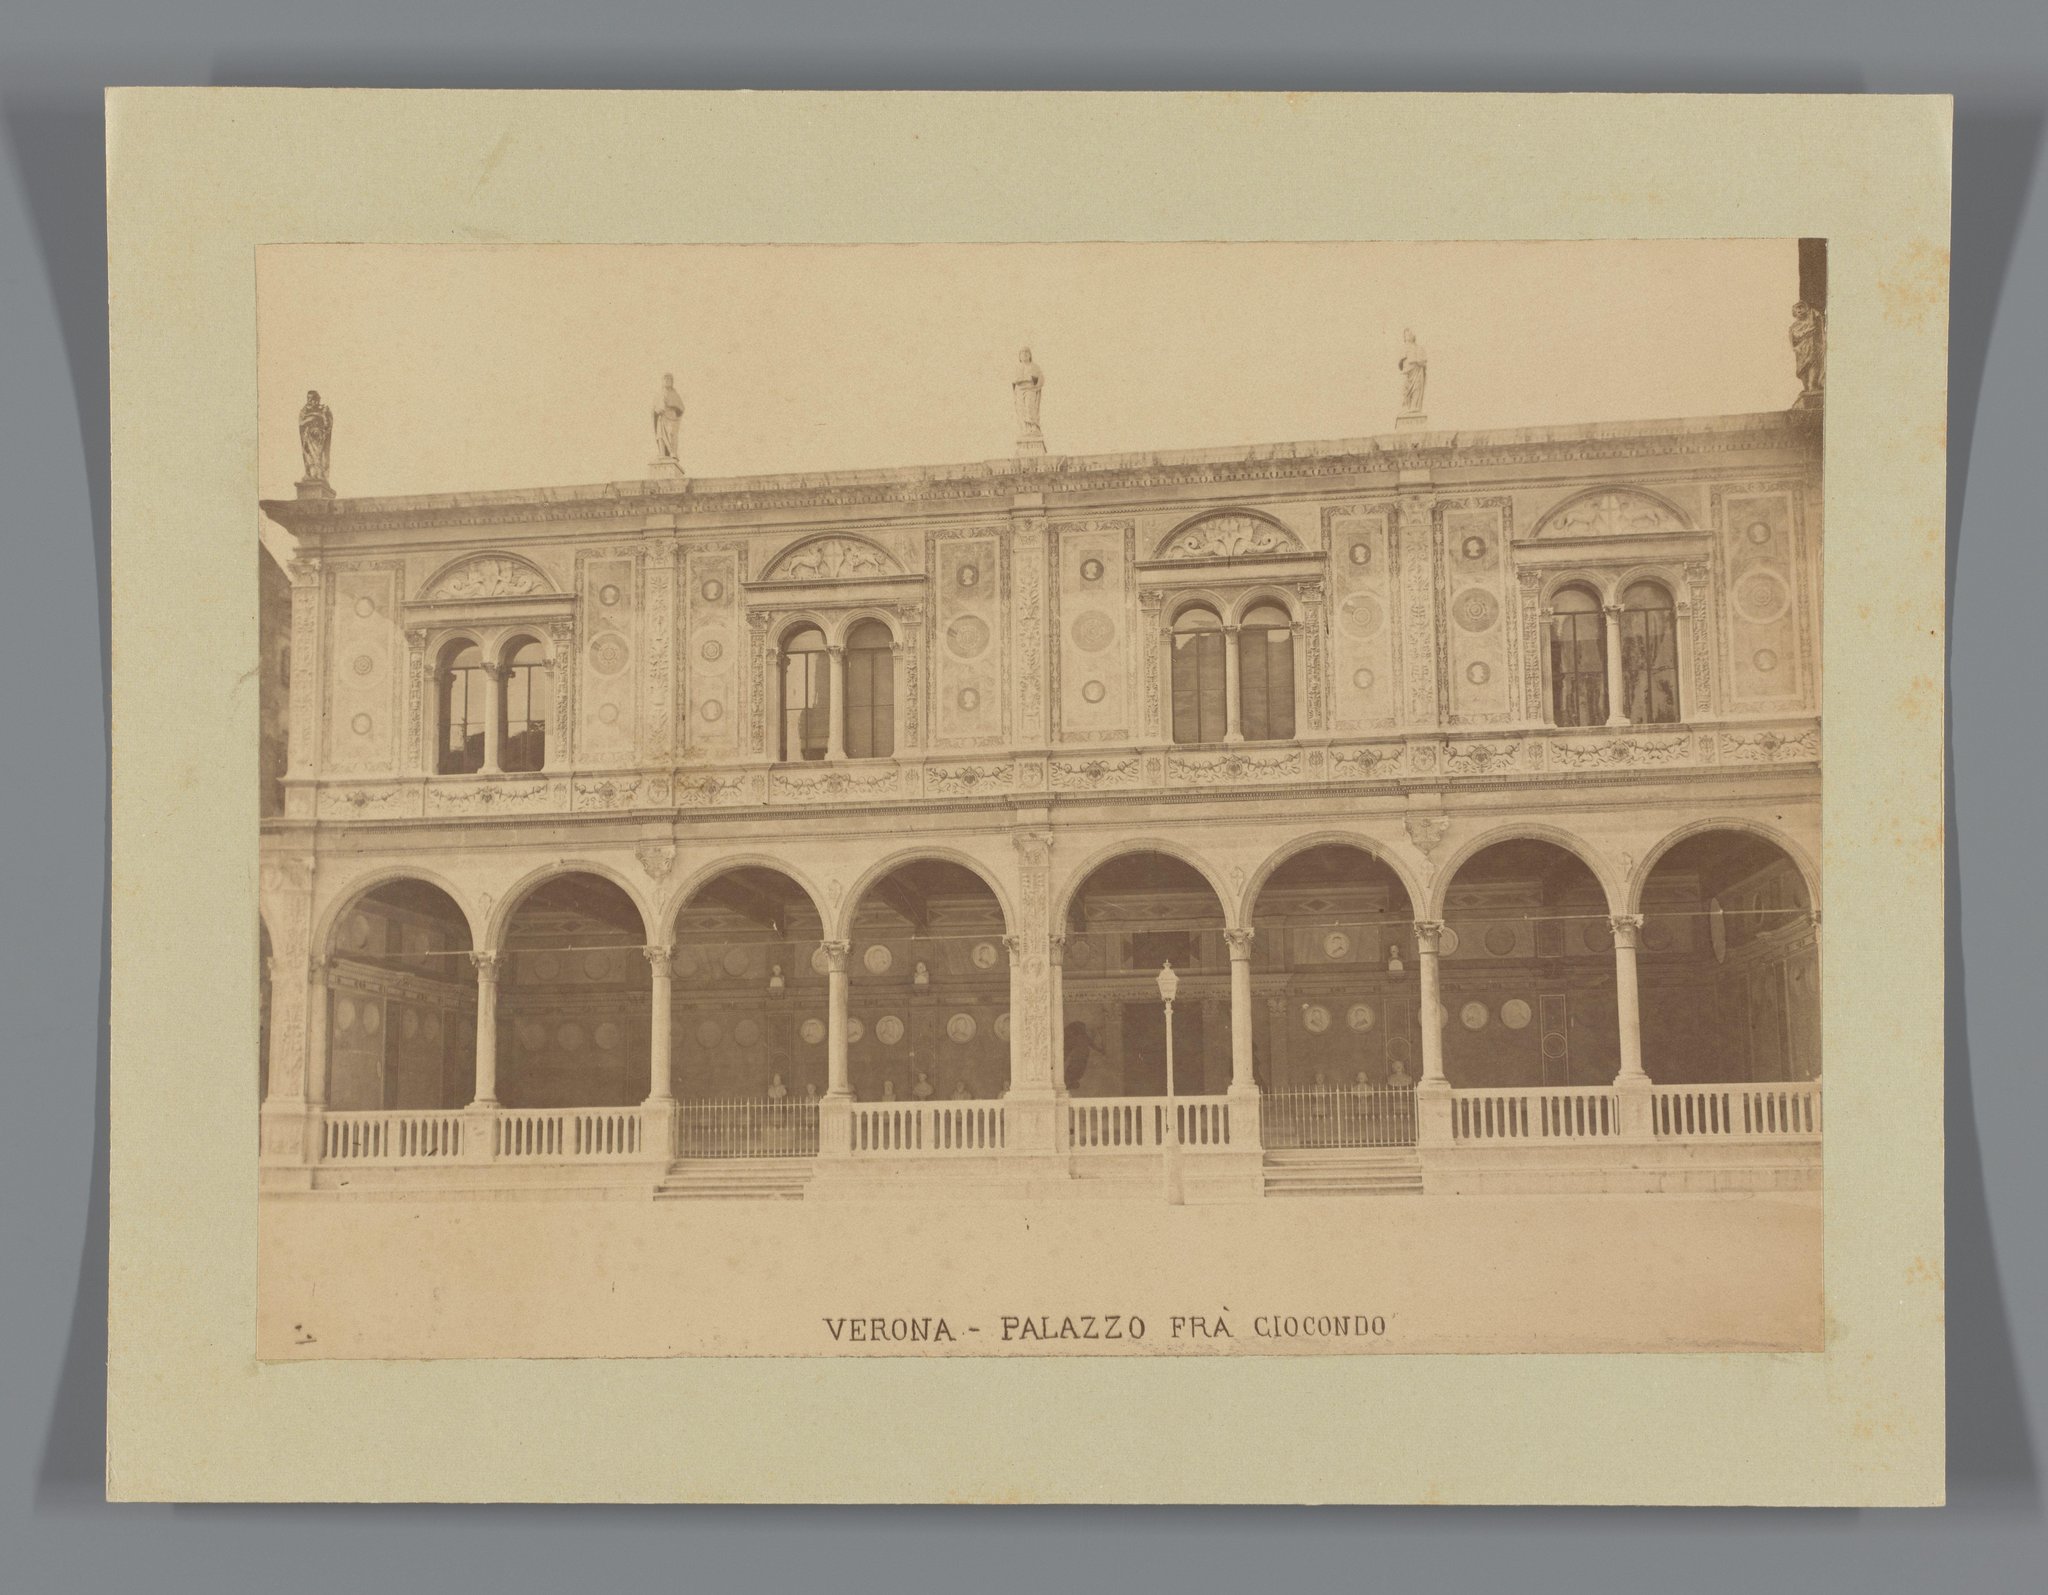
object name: photograph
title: Italië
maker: Anonymous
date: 1880-1910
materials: photographic support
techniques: albumen print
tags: italy